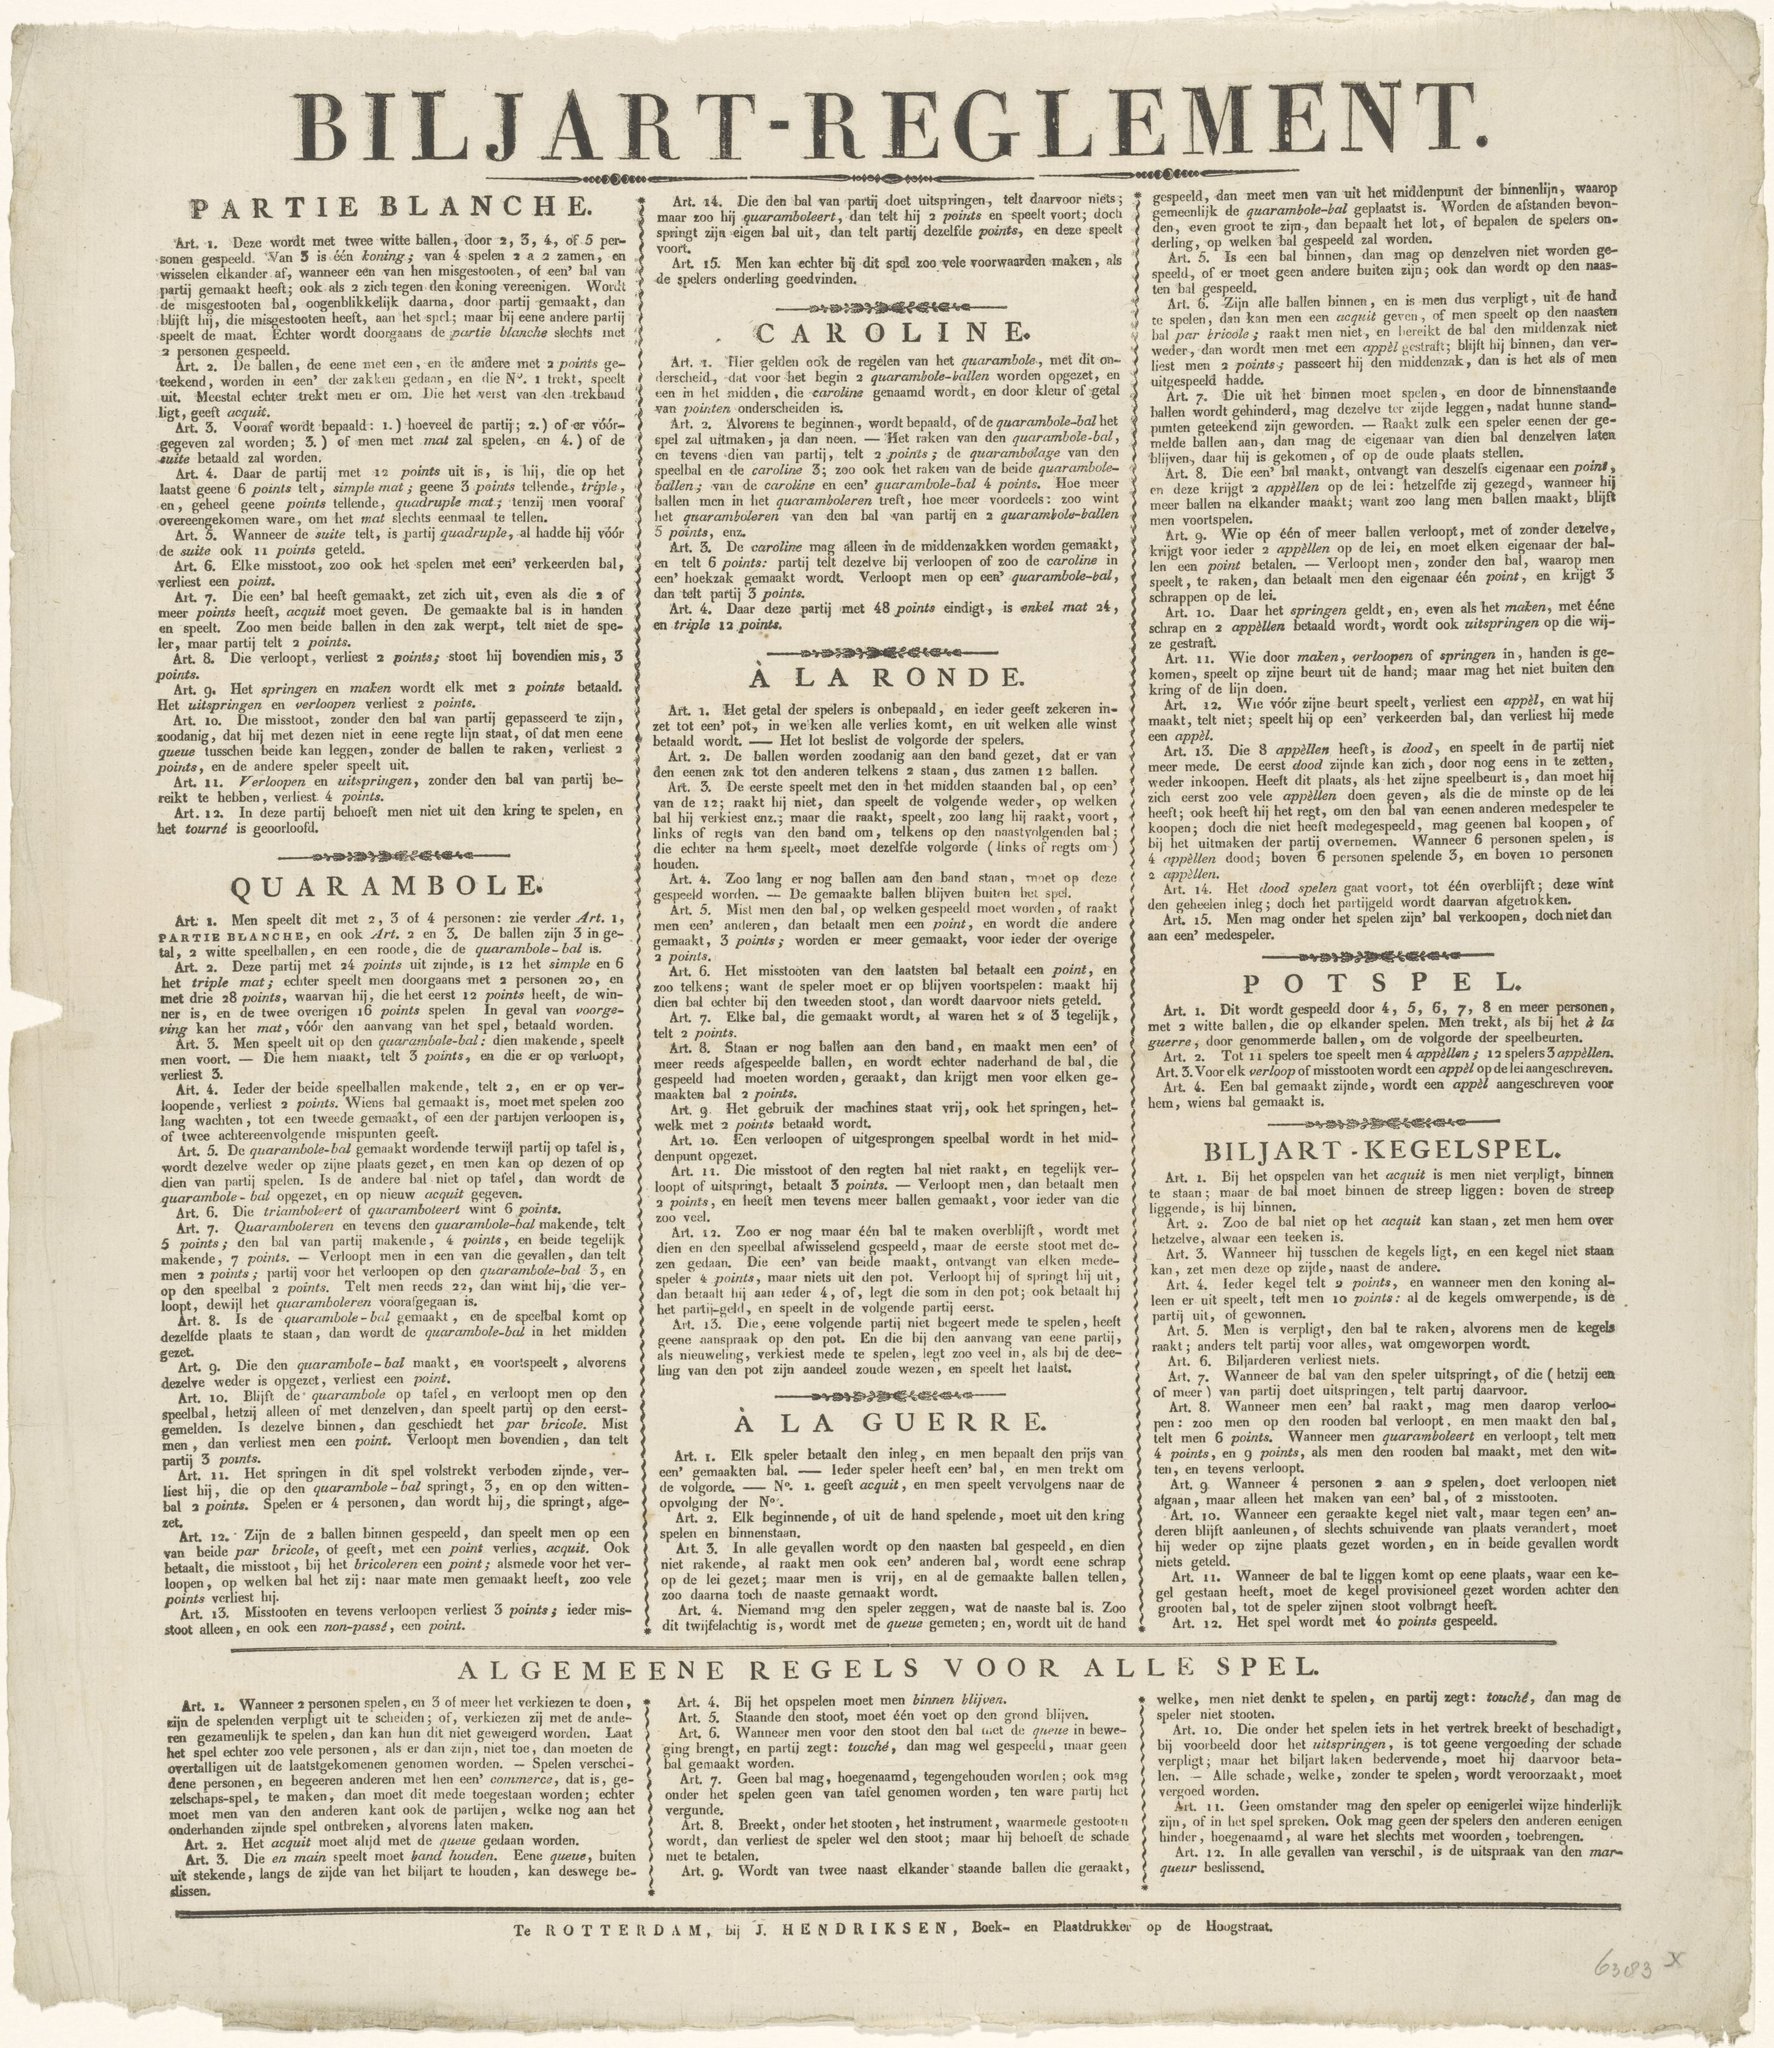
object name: text sheet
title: Regels van het biljartspel, ca. 1780-1790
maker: jan hendriksen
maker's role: bookseller, printer, publisher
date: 1780-1790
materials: paper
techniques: letterpress printing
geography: rotterdam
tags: billiards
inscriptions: collector's mark: Lugt 2228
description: Tekstblad met de spelregels voor verschillende soorten biljartspelen. Tekst in drie kolommen. Onderdeel van een groep van kinder- en gezelschapsspelen gedrukt in de periode ca. 1750-1850.